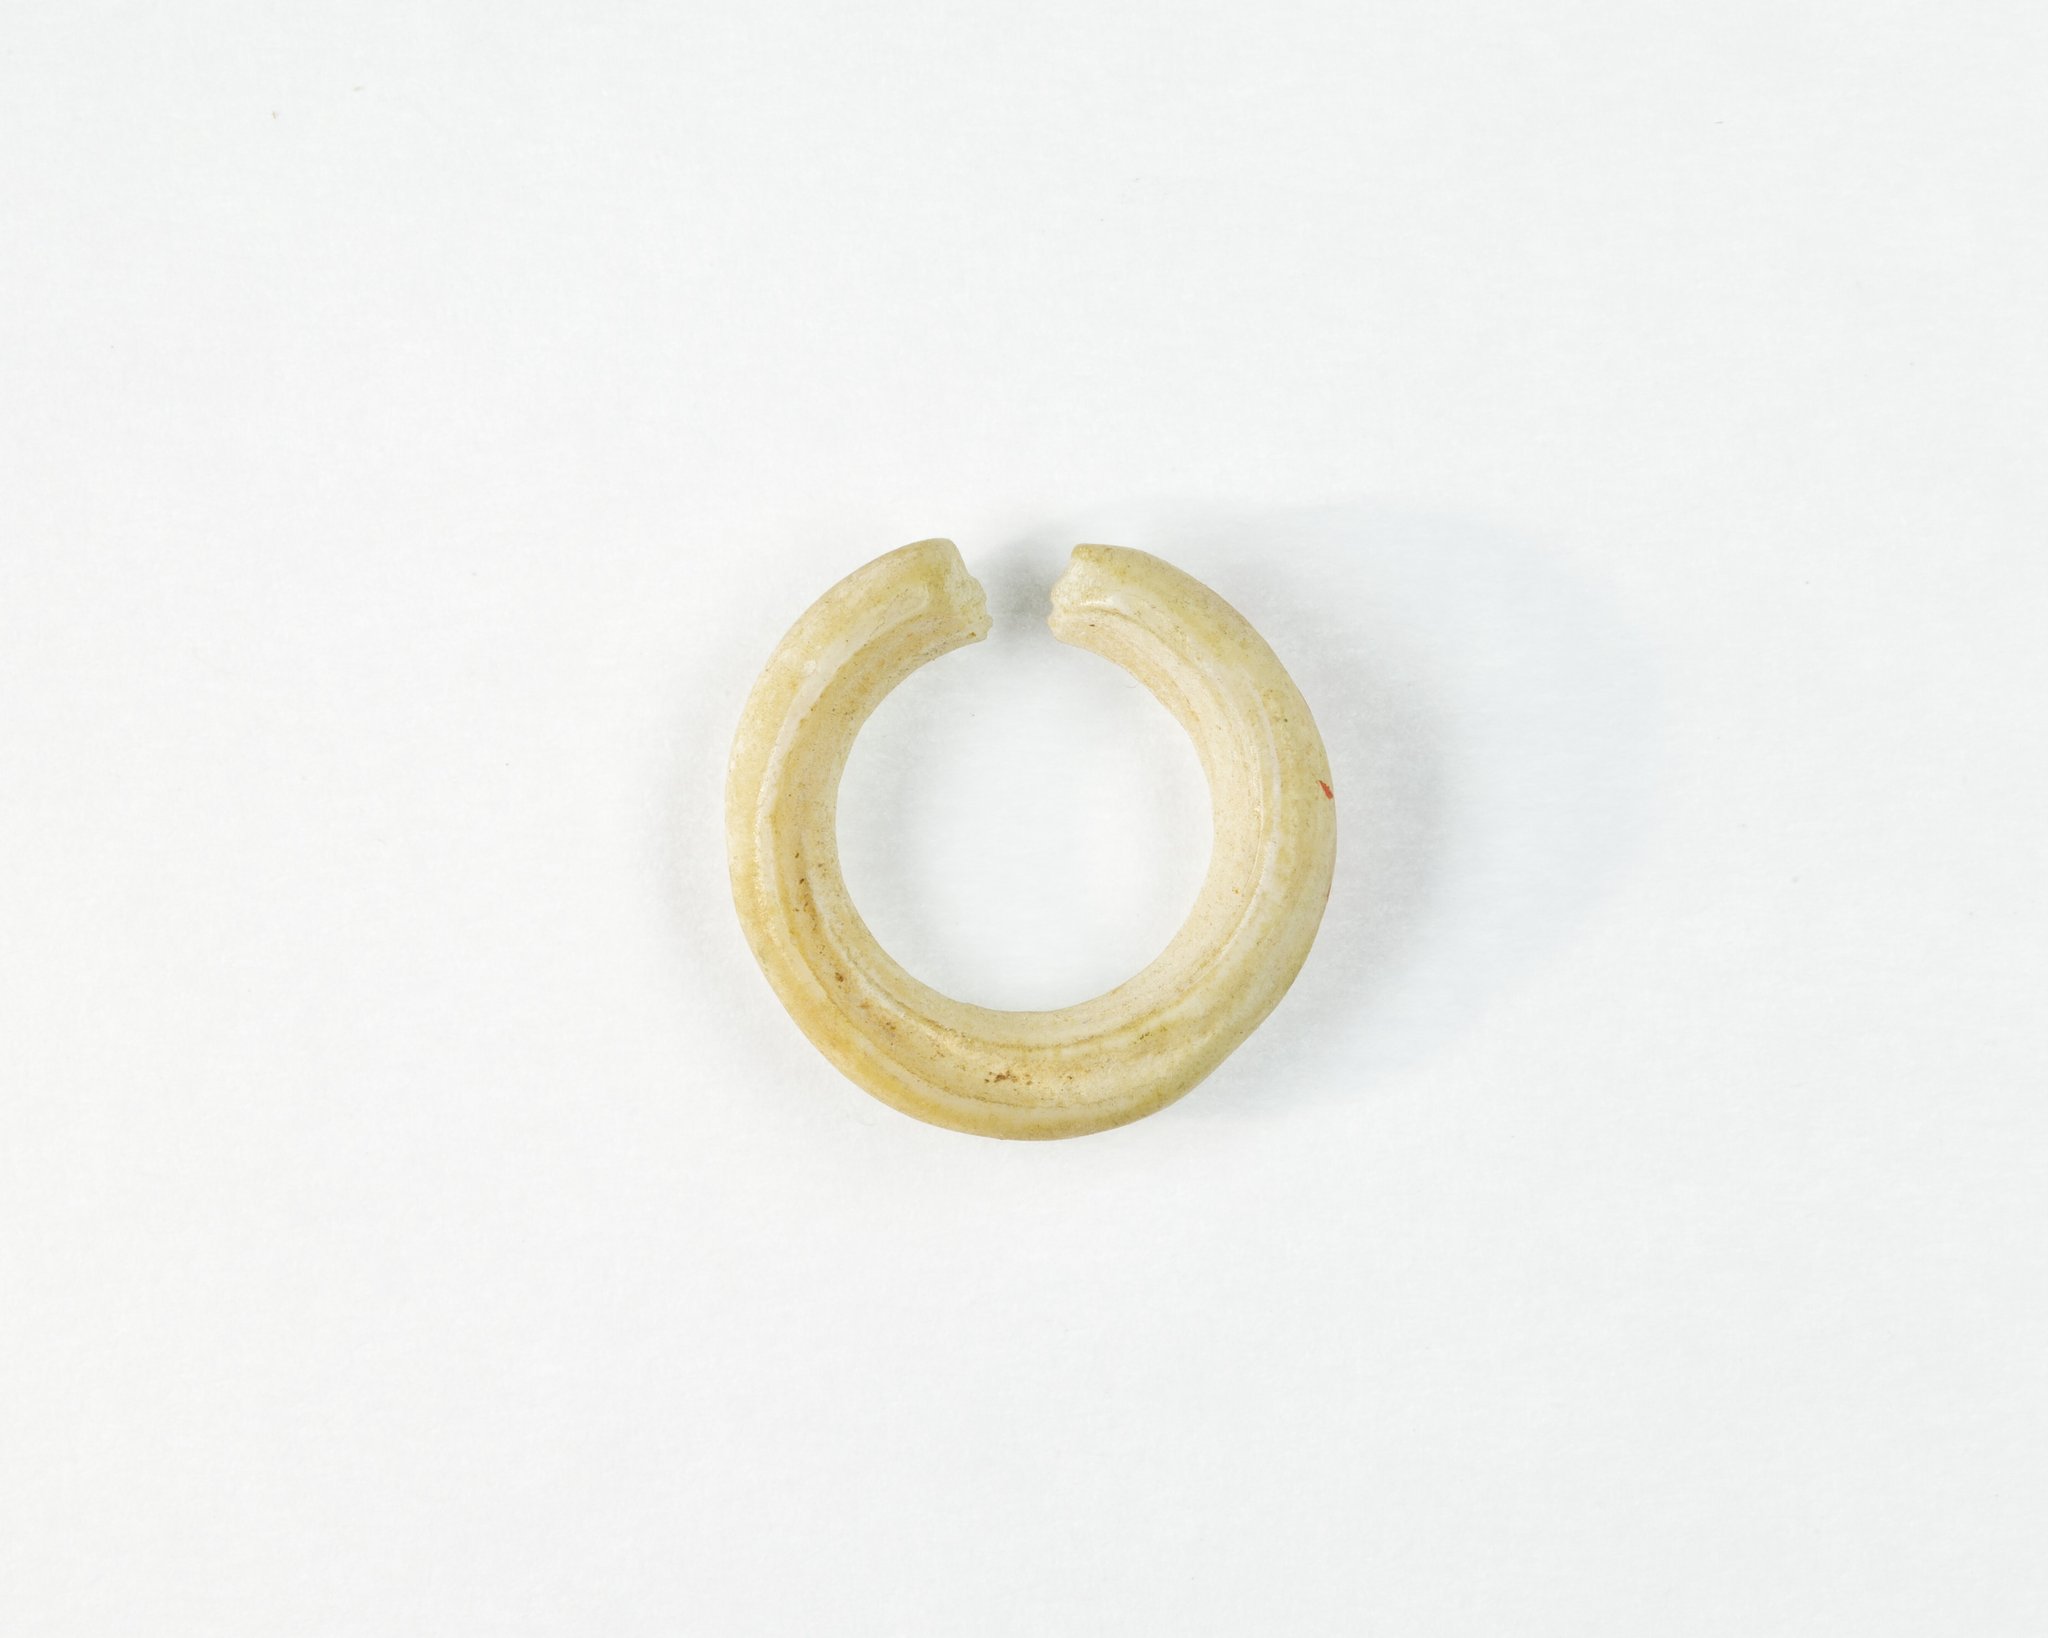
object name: earring, penannular, circular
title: Penannular Earring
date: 1550-1295 BCE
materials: shell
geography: northern upper egypt